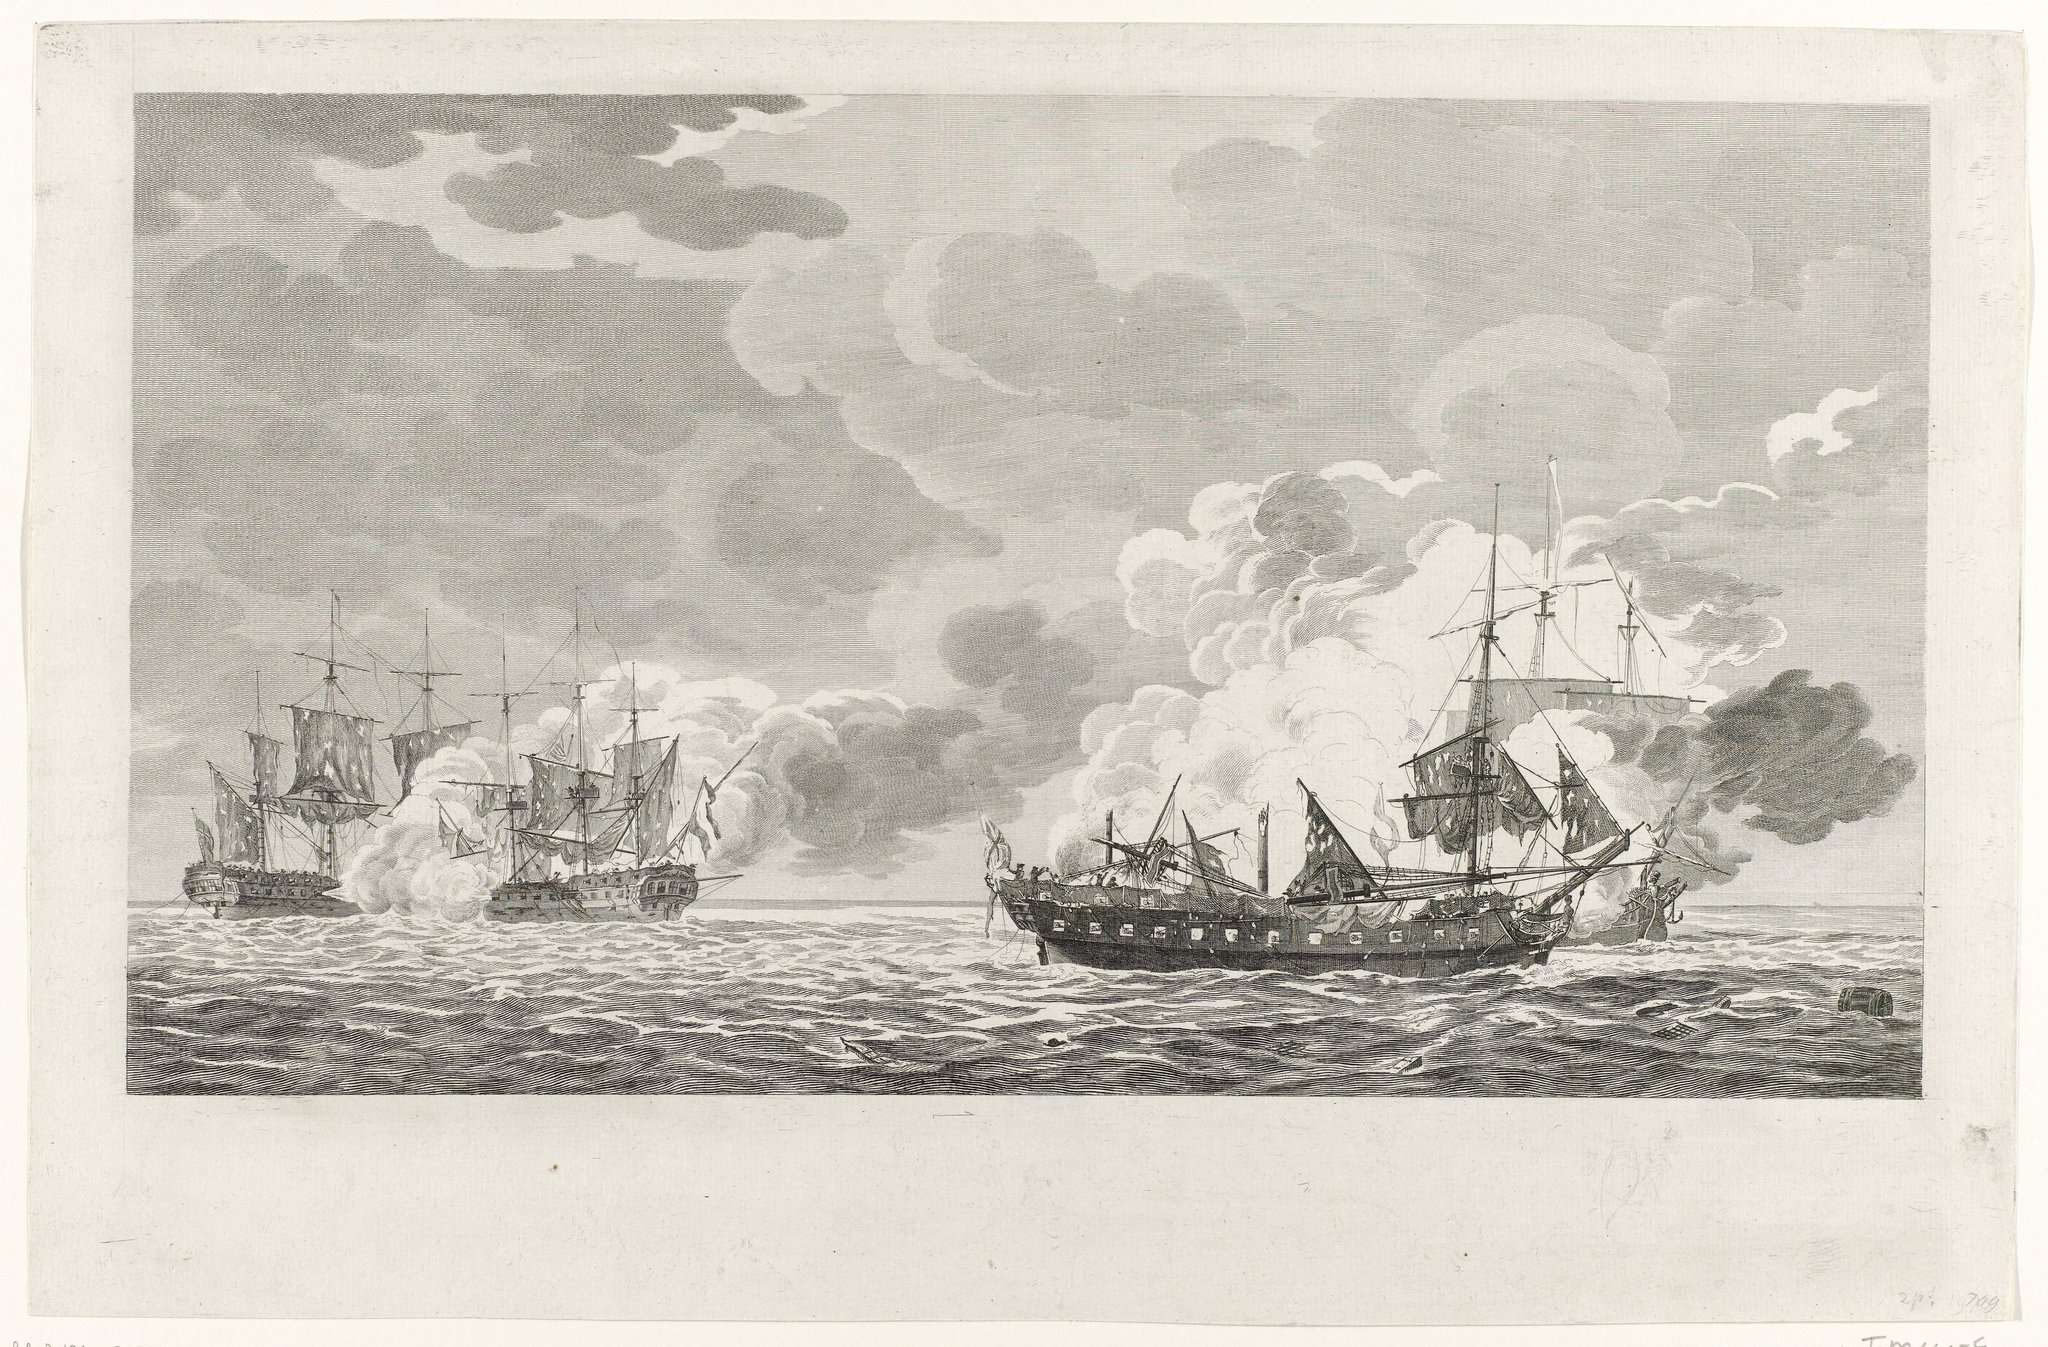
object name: print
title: Zeeslag bij Cadiz, 1781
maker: mathias de sallieth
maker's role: print maker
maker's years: 1749-1791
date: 1782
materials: paper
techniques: engraving, etching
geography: northern netherlands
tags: dordrecht, the hague, naval officer, pieter melvill van carnbee, gerardus oorthuys, battle (+ naval force)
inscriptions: collector's mark: Lugt 2228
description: Zeegevecht bij Cadiz tussen twee Nederlandse fregatten Castor en Den Briel en twee Engelse fregatten Flora en Crescent, 30 mei 1781.